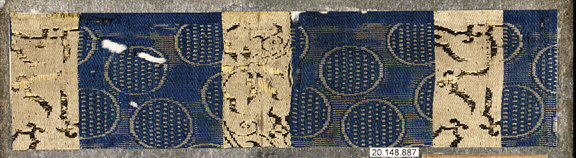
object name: piece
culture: chinese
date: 1601-1700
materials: silk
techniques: compound weave